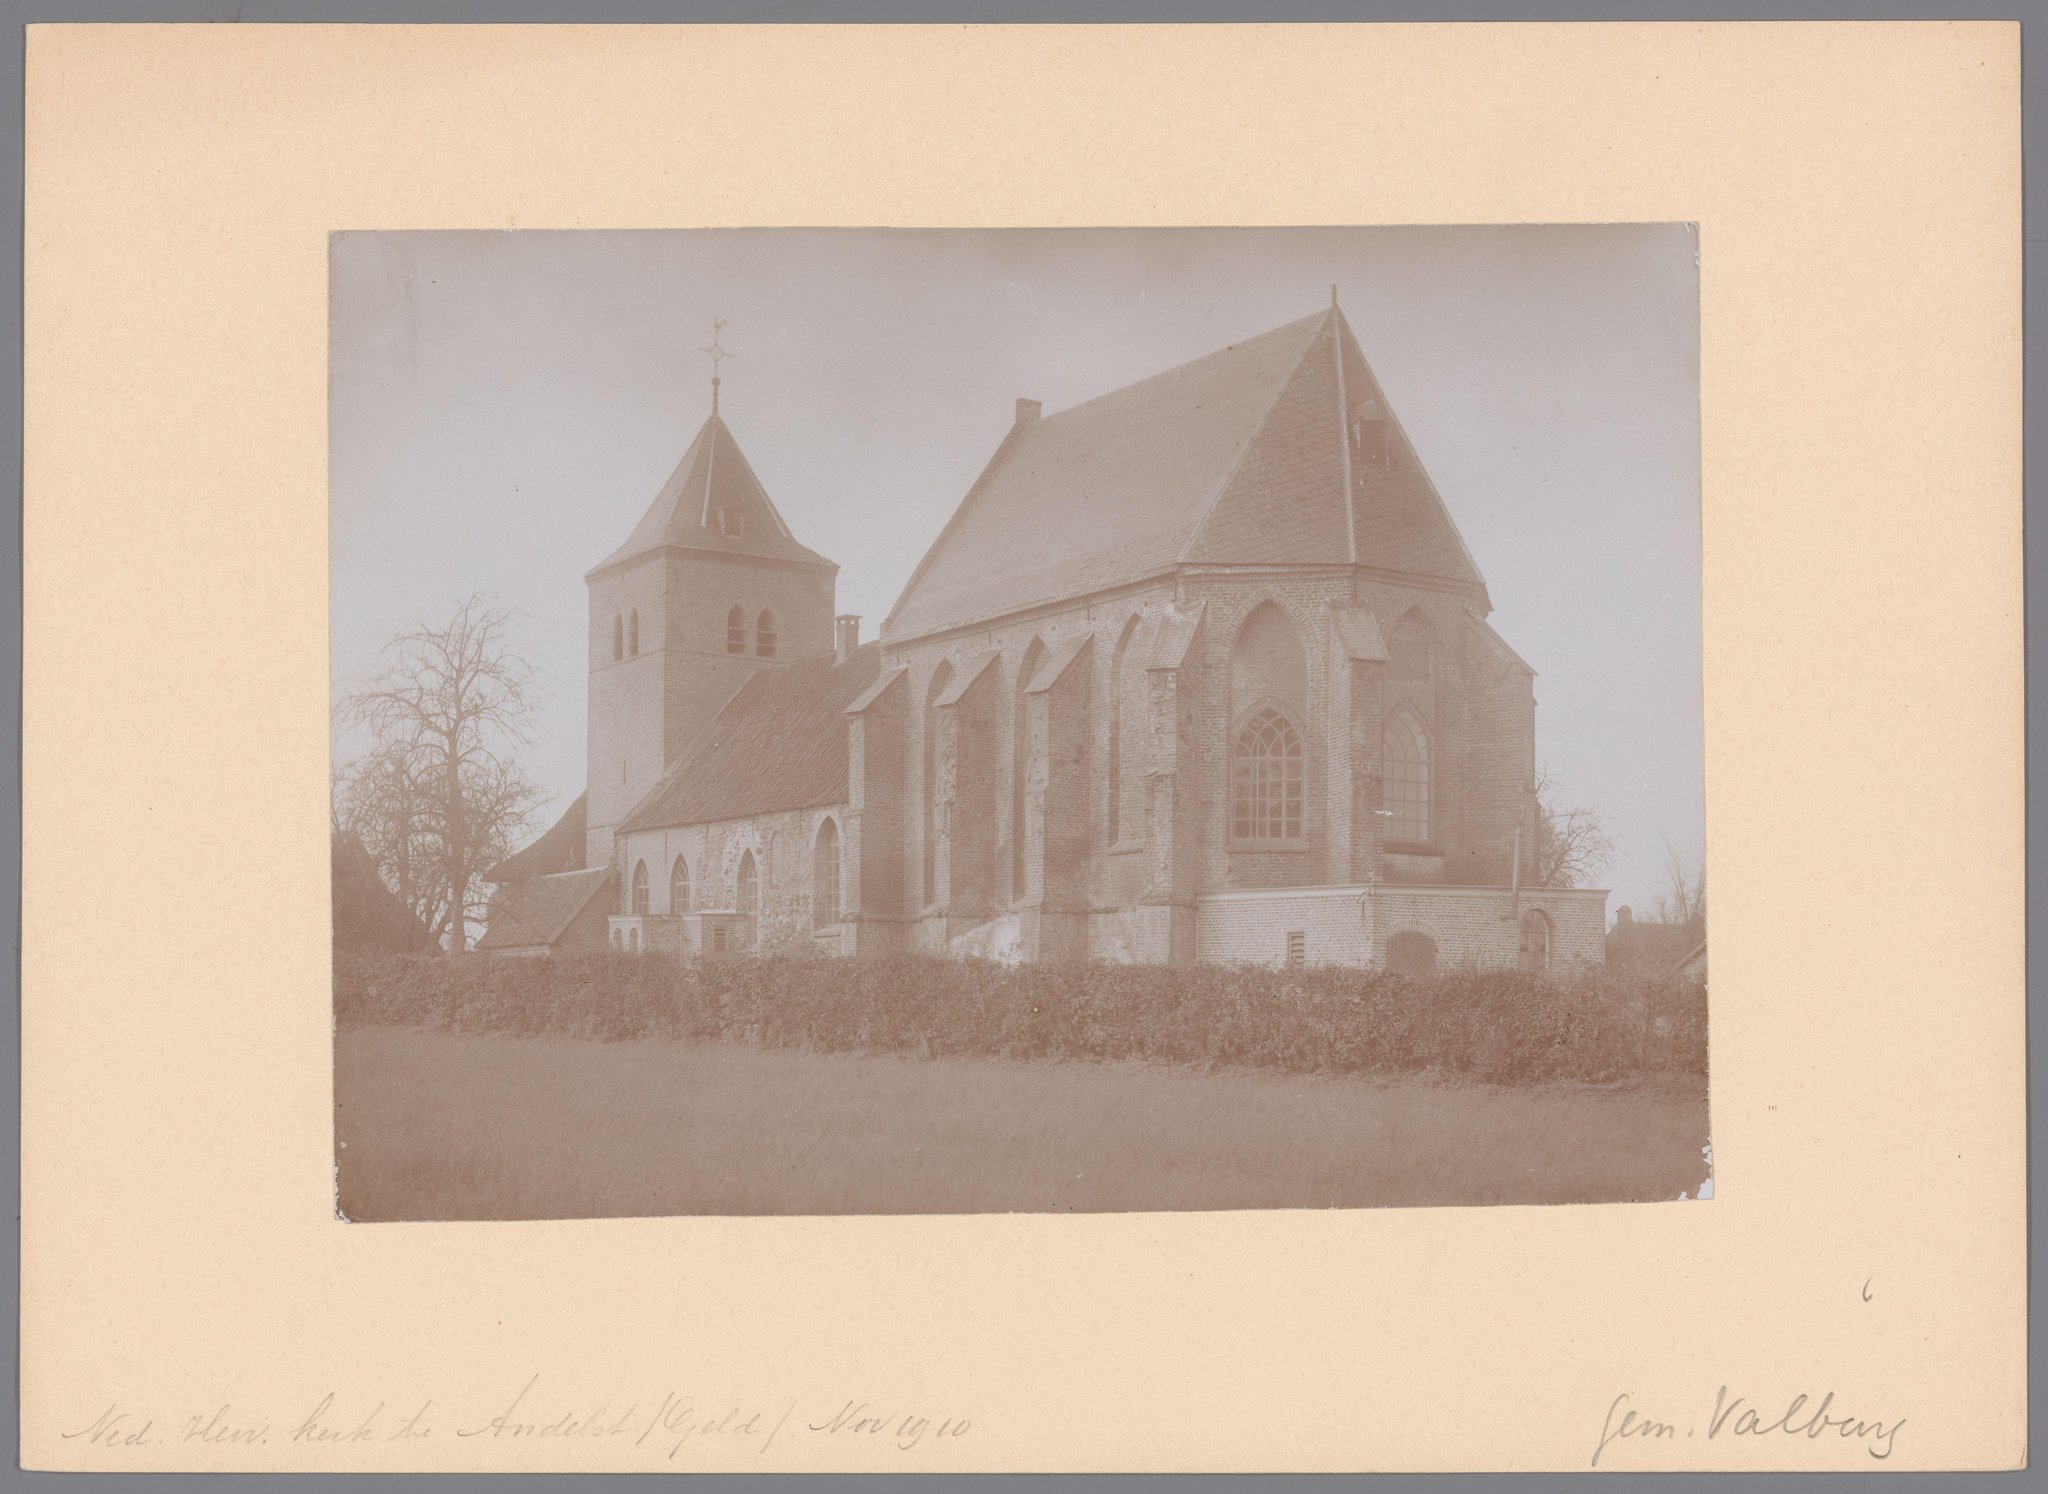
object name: photograph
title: Gezicht op de Hervormde Kerk van Andelst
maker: anoniem (monumentenzorg)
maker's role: fotograaf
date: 1910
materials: cardboard, photographic support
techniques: collodion silver print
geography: andelst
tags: church (exterior)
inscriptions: annotation: ‘Ned. Herv. kerk te Andelst/ Geld./ Nov 1910/ Gem. Valburg’